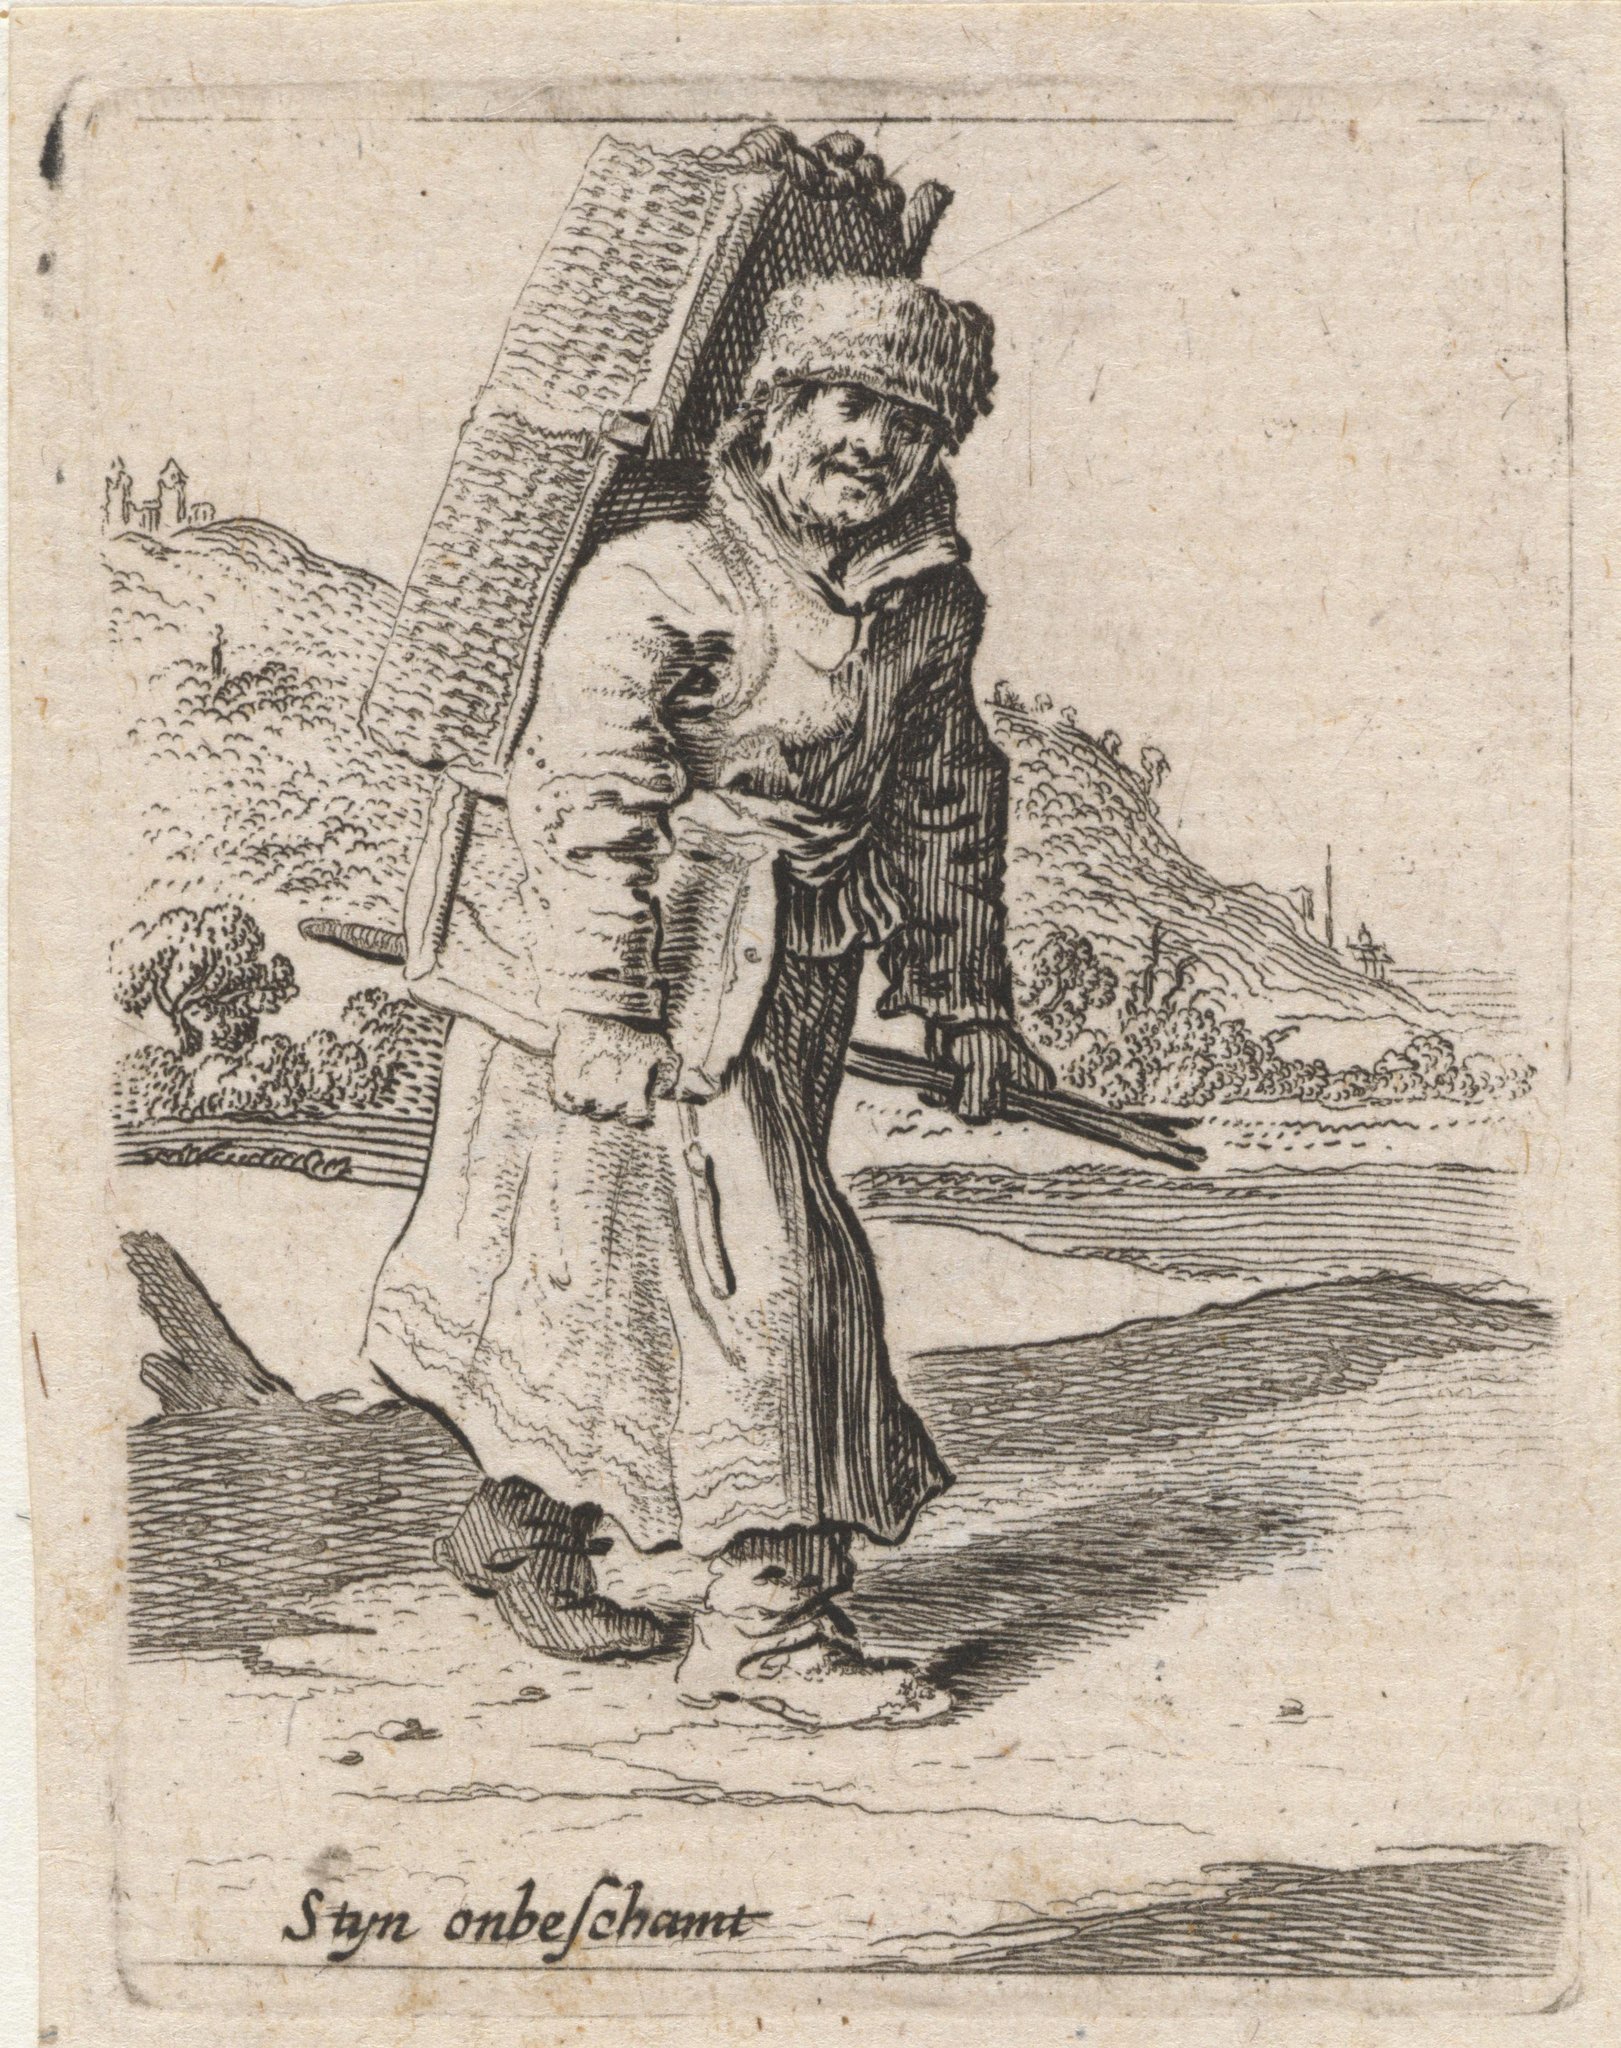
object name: print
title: Genretaferelen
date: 1638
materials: paper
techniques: etching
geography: amsterdam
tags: carrying something in basket, bag, rucksack, etc.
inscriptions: collector's mark: Lugt 2760, collector's mark: Lugt 2228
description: Een man (Styn onbeschamt) met op het hoofd een muts en op de rug een grote mand loopt naar rechts. Op de achtergrond een heuvel. De prent maakt deel uit van een serie van 32 prenten met genretaferelen.